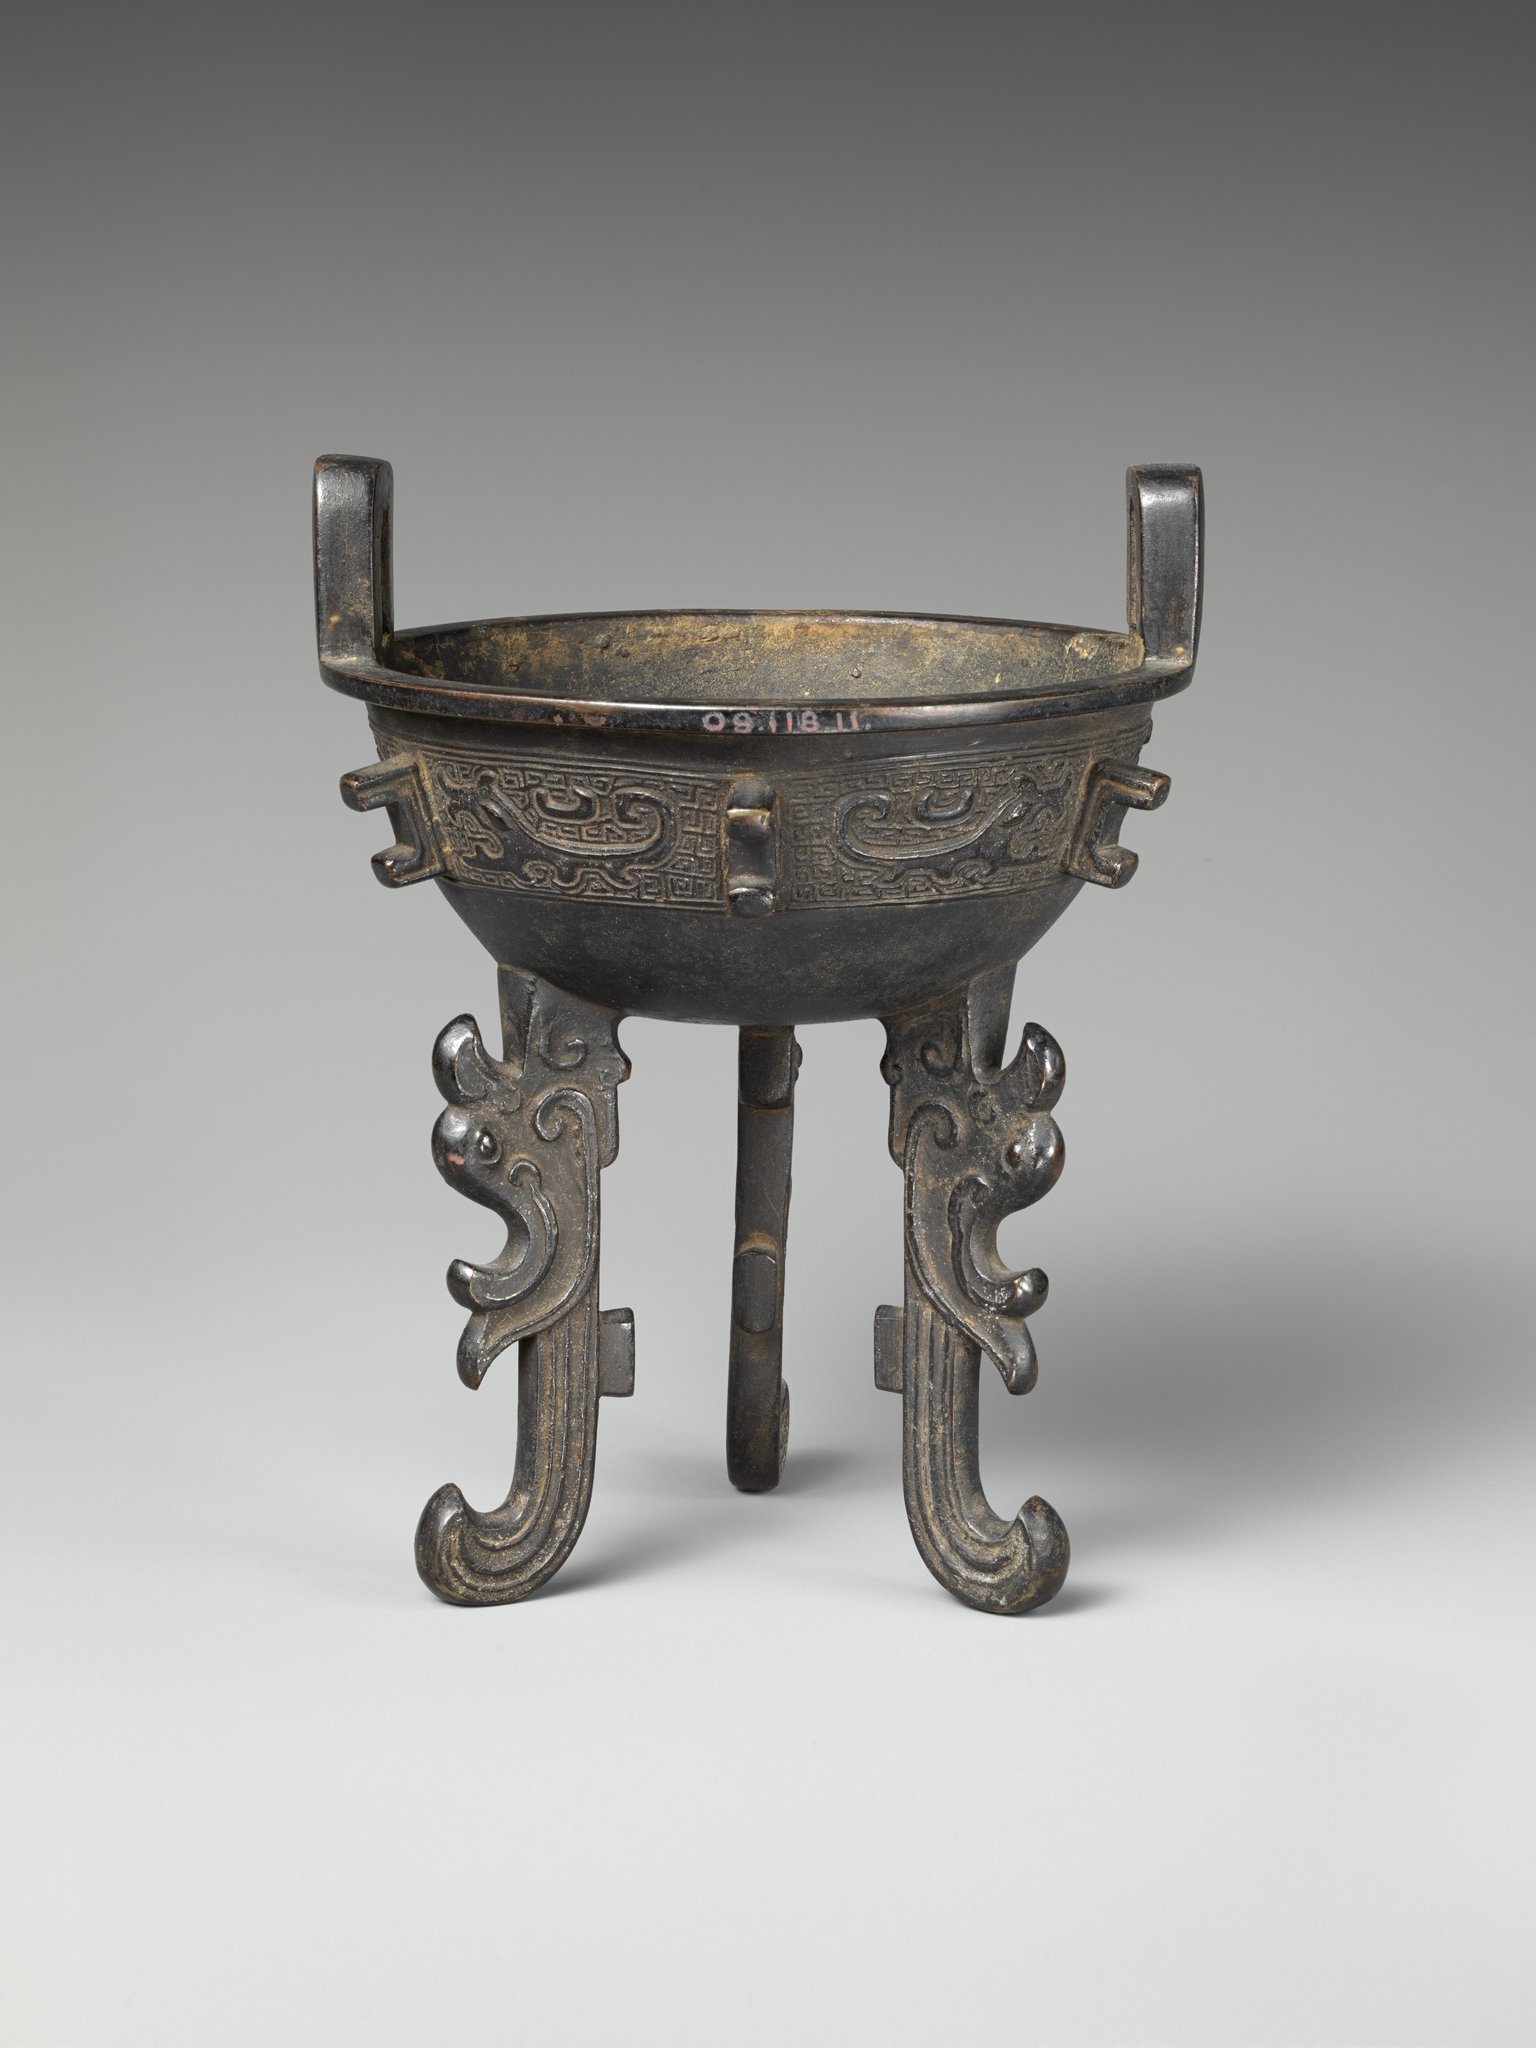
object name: vessel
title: Three-Legged Vessel of Archaistic Design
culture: chinese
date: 1667-1733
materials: bronze